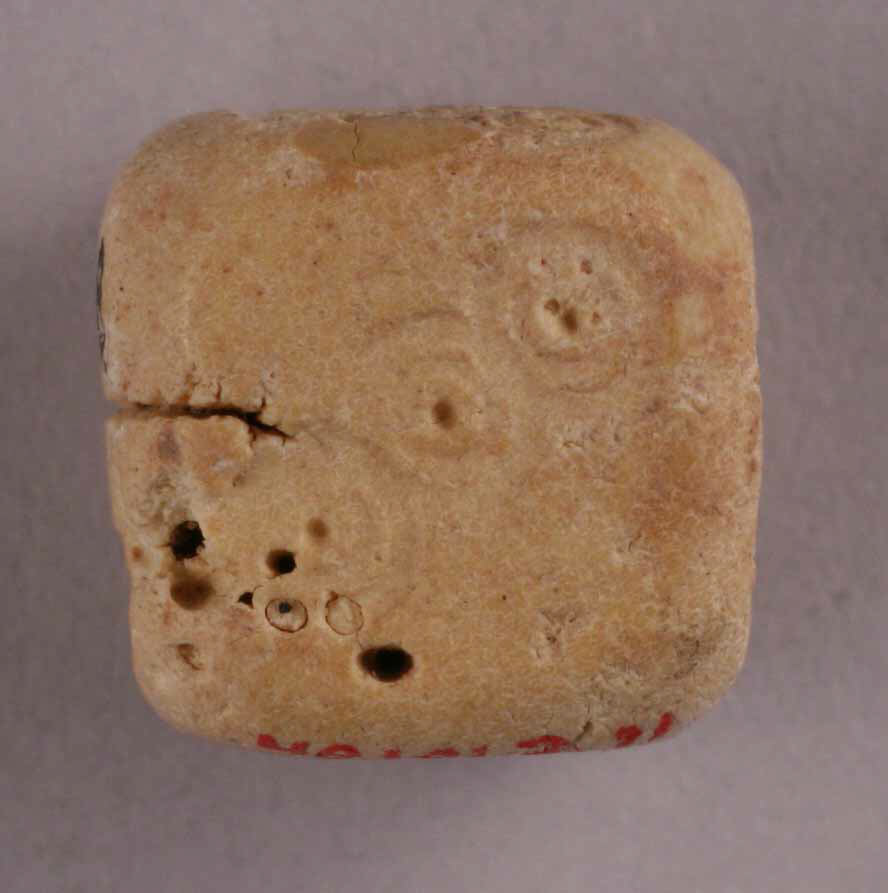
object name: dice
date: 801-1000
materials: bone, paint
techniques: incising, inlay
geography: iran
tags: dice